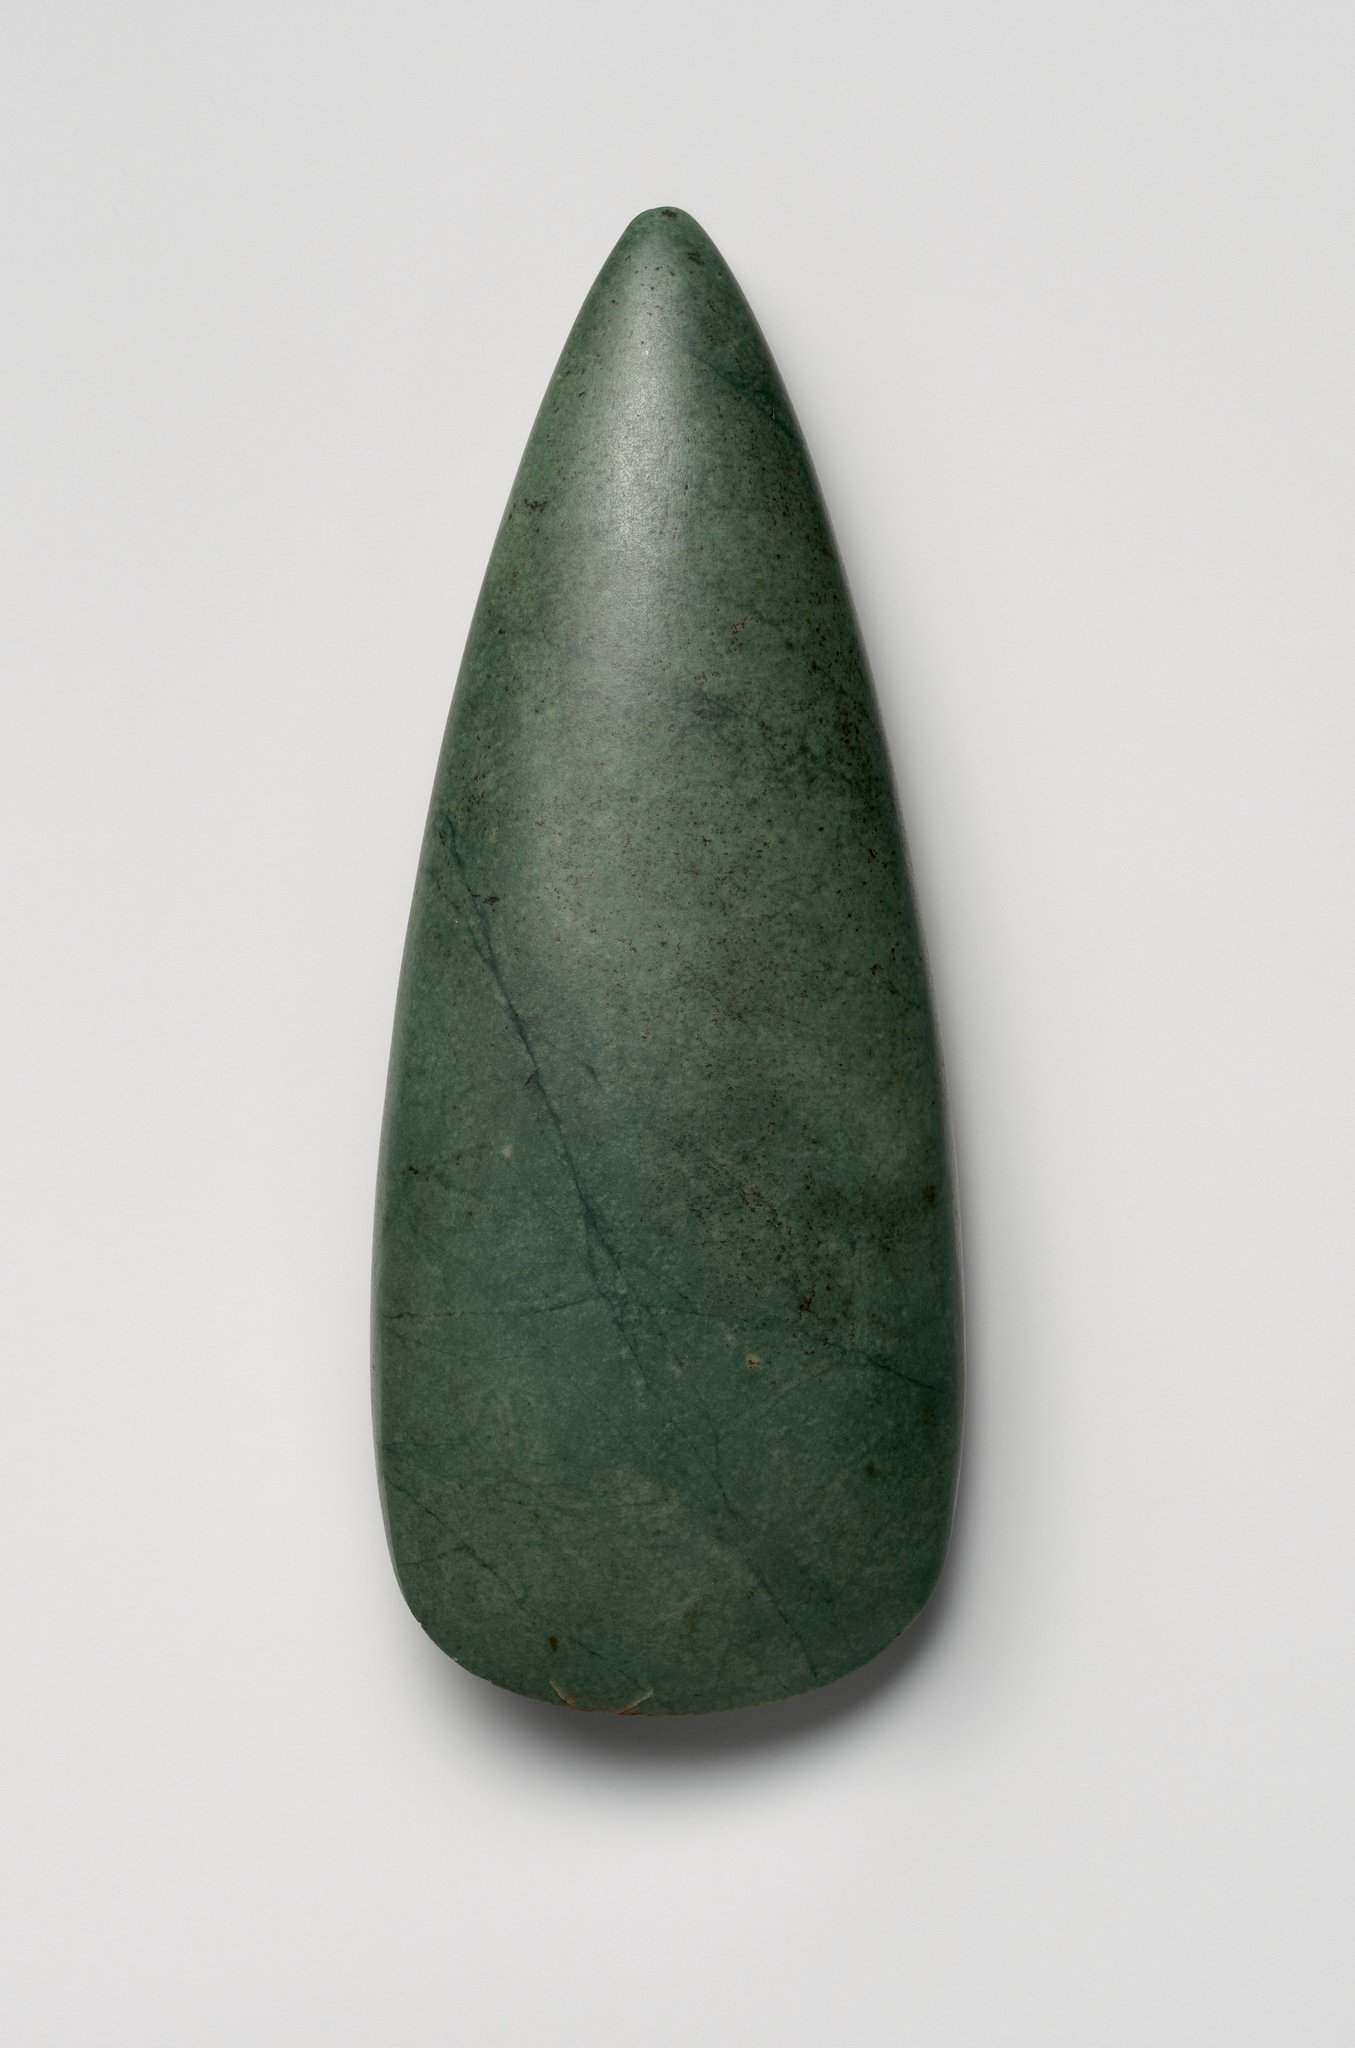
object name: celt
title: Ceremonial axe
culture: taíno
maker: taíno artist(s)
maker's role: artist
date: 600-1500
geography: dominican republic